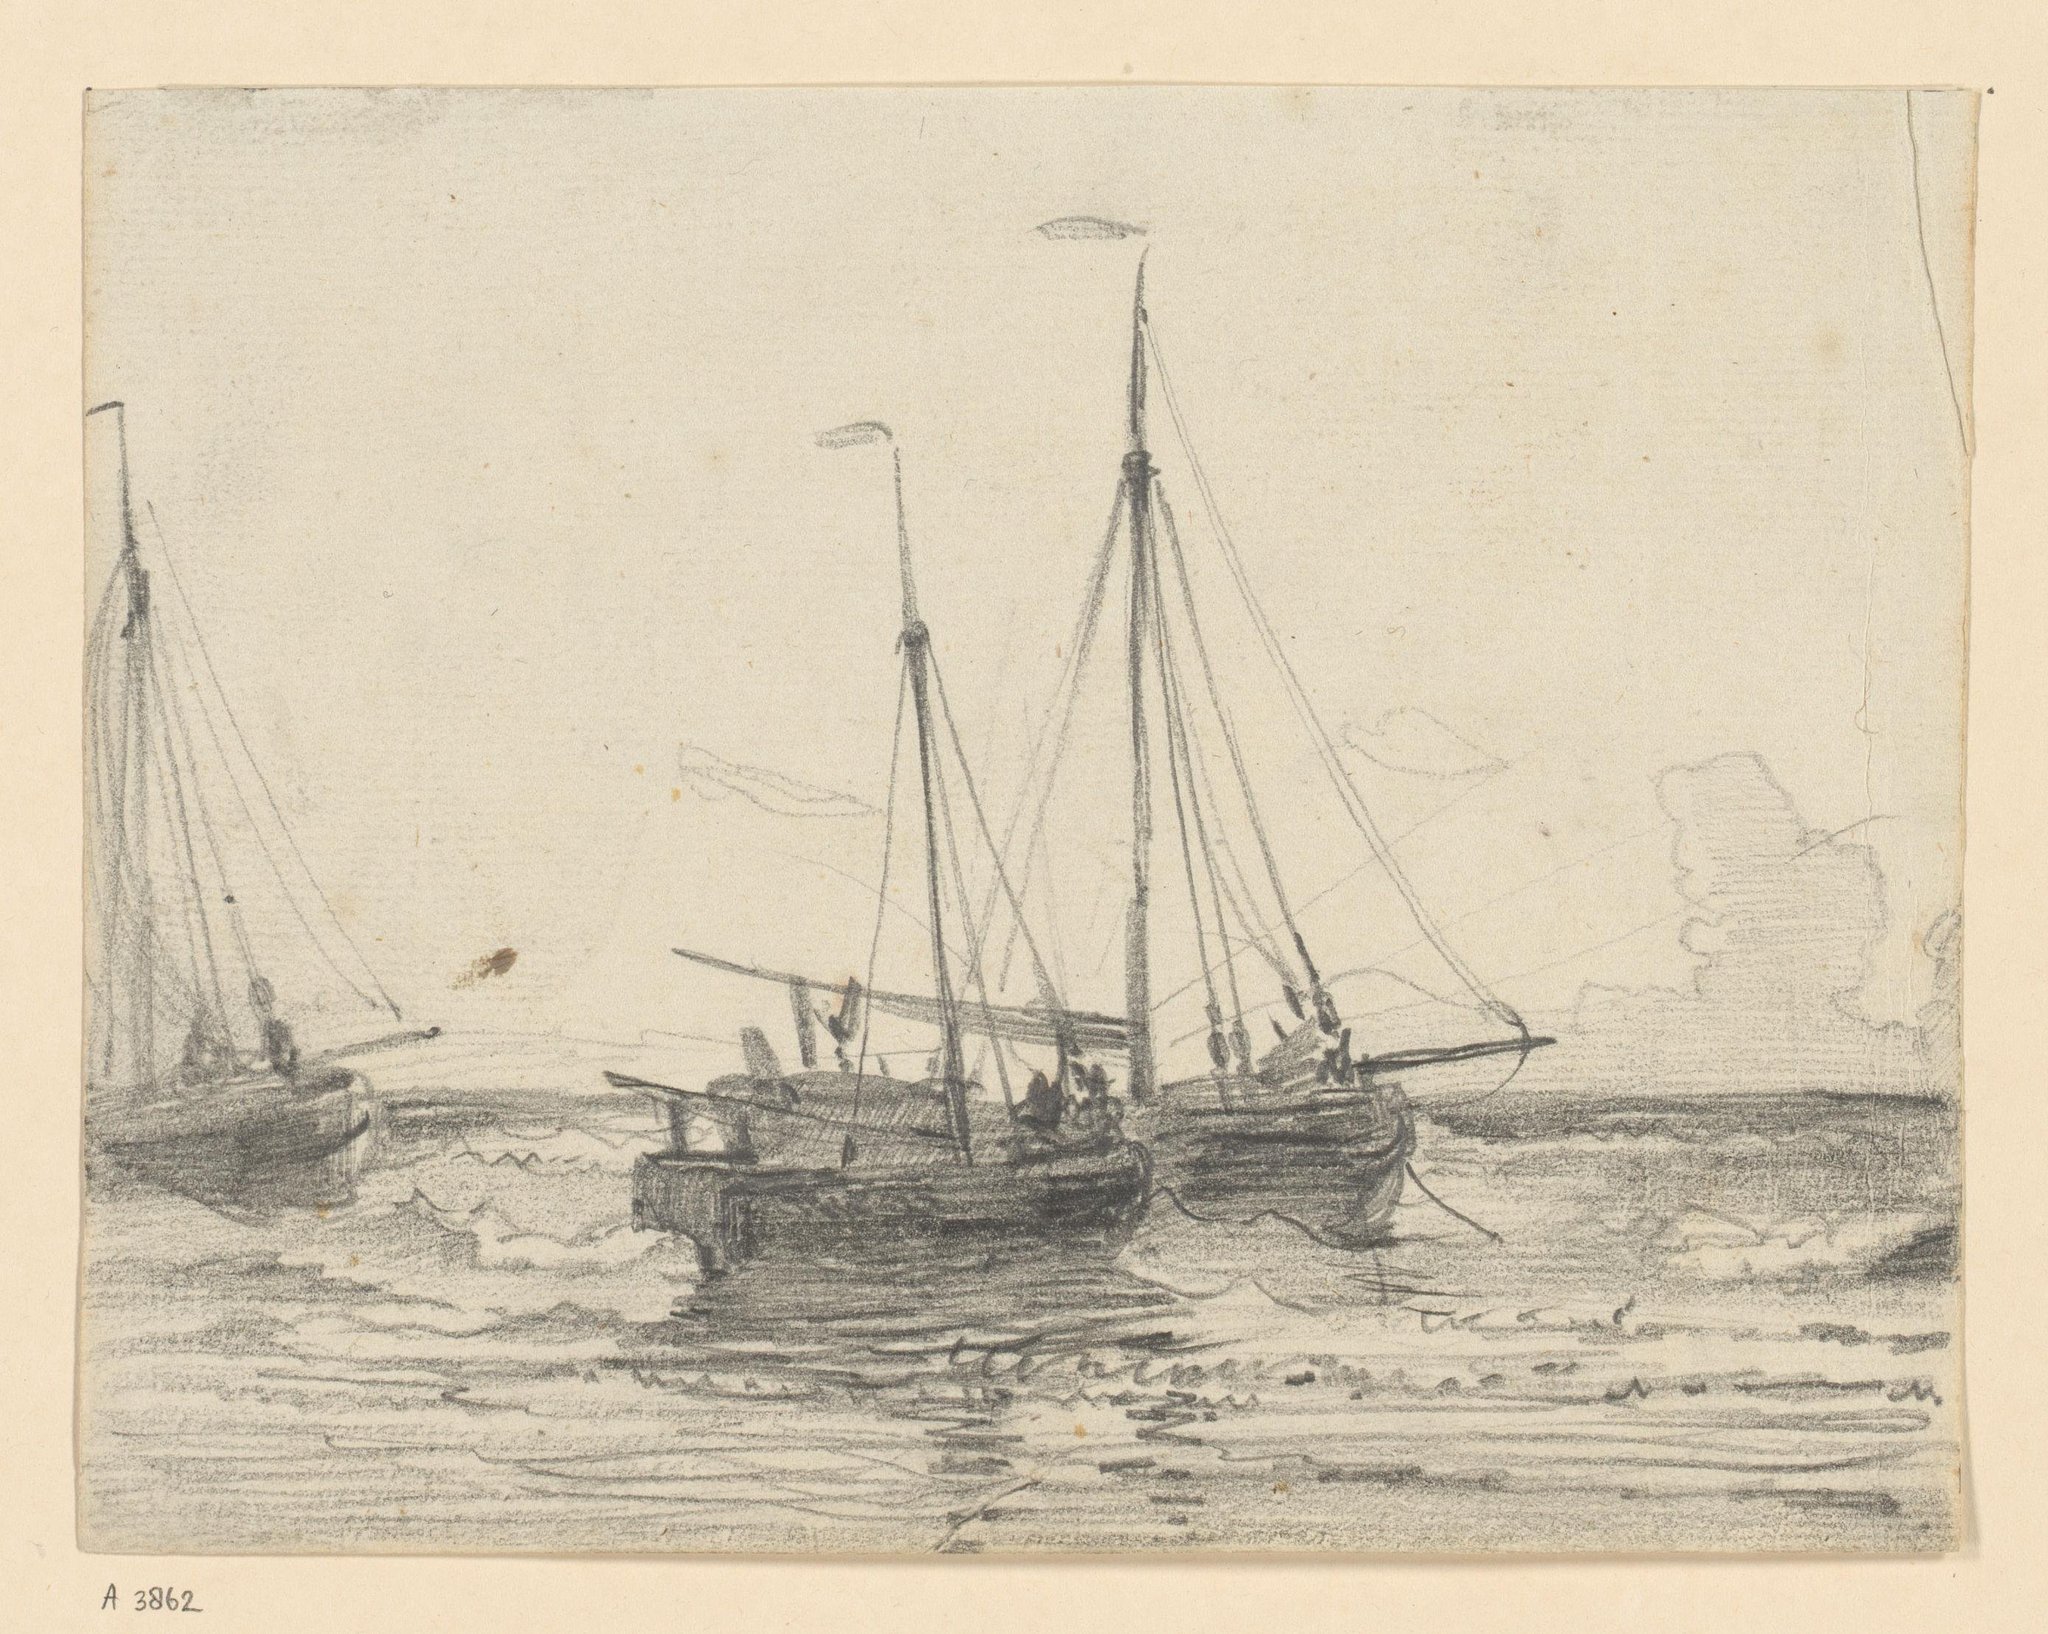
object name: drawing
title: Vissersboten in de branding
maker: willem anthonie van deventer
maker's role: draughtsman, painter, print maker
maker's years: 1824-1893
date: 1834-1893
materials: paper, pencil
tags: sailing-ship, sailing-boat, beach